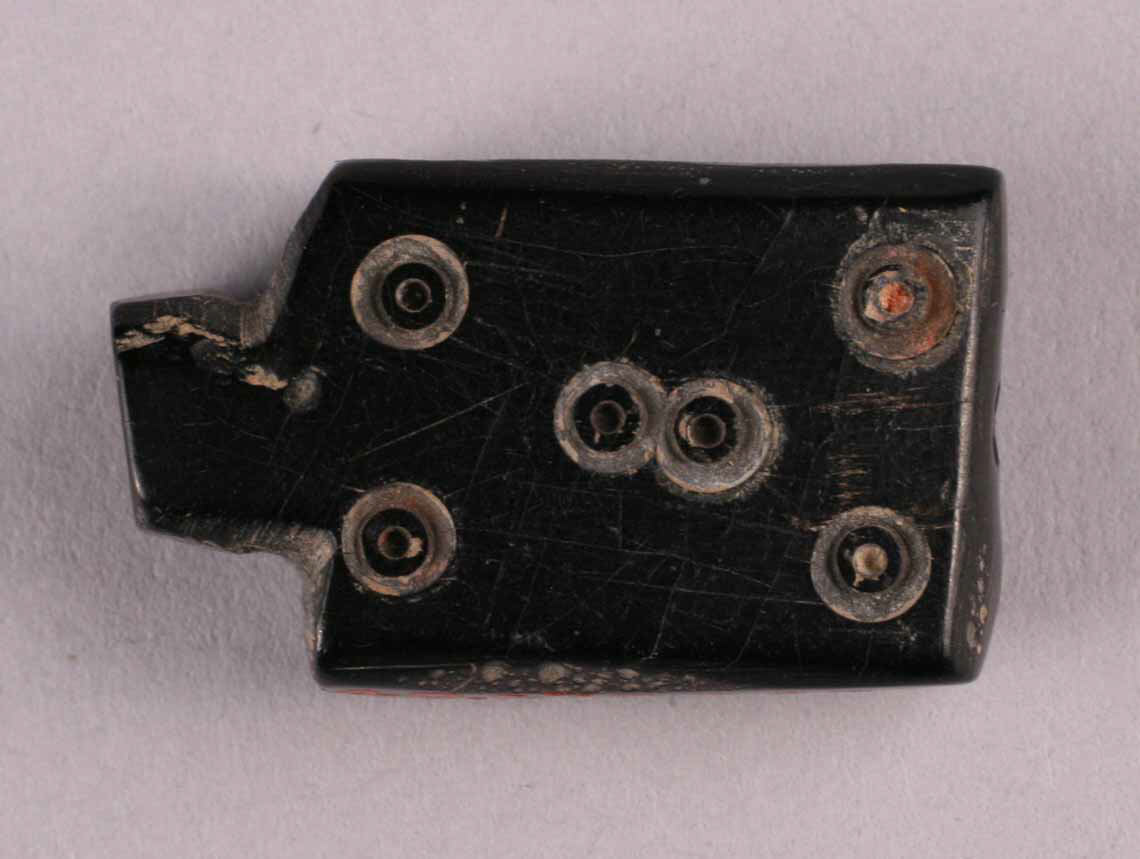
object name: jewellery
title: Jewelry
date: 701-1200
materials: bone, stone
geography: iran